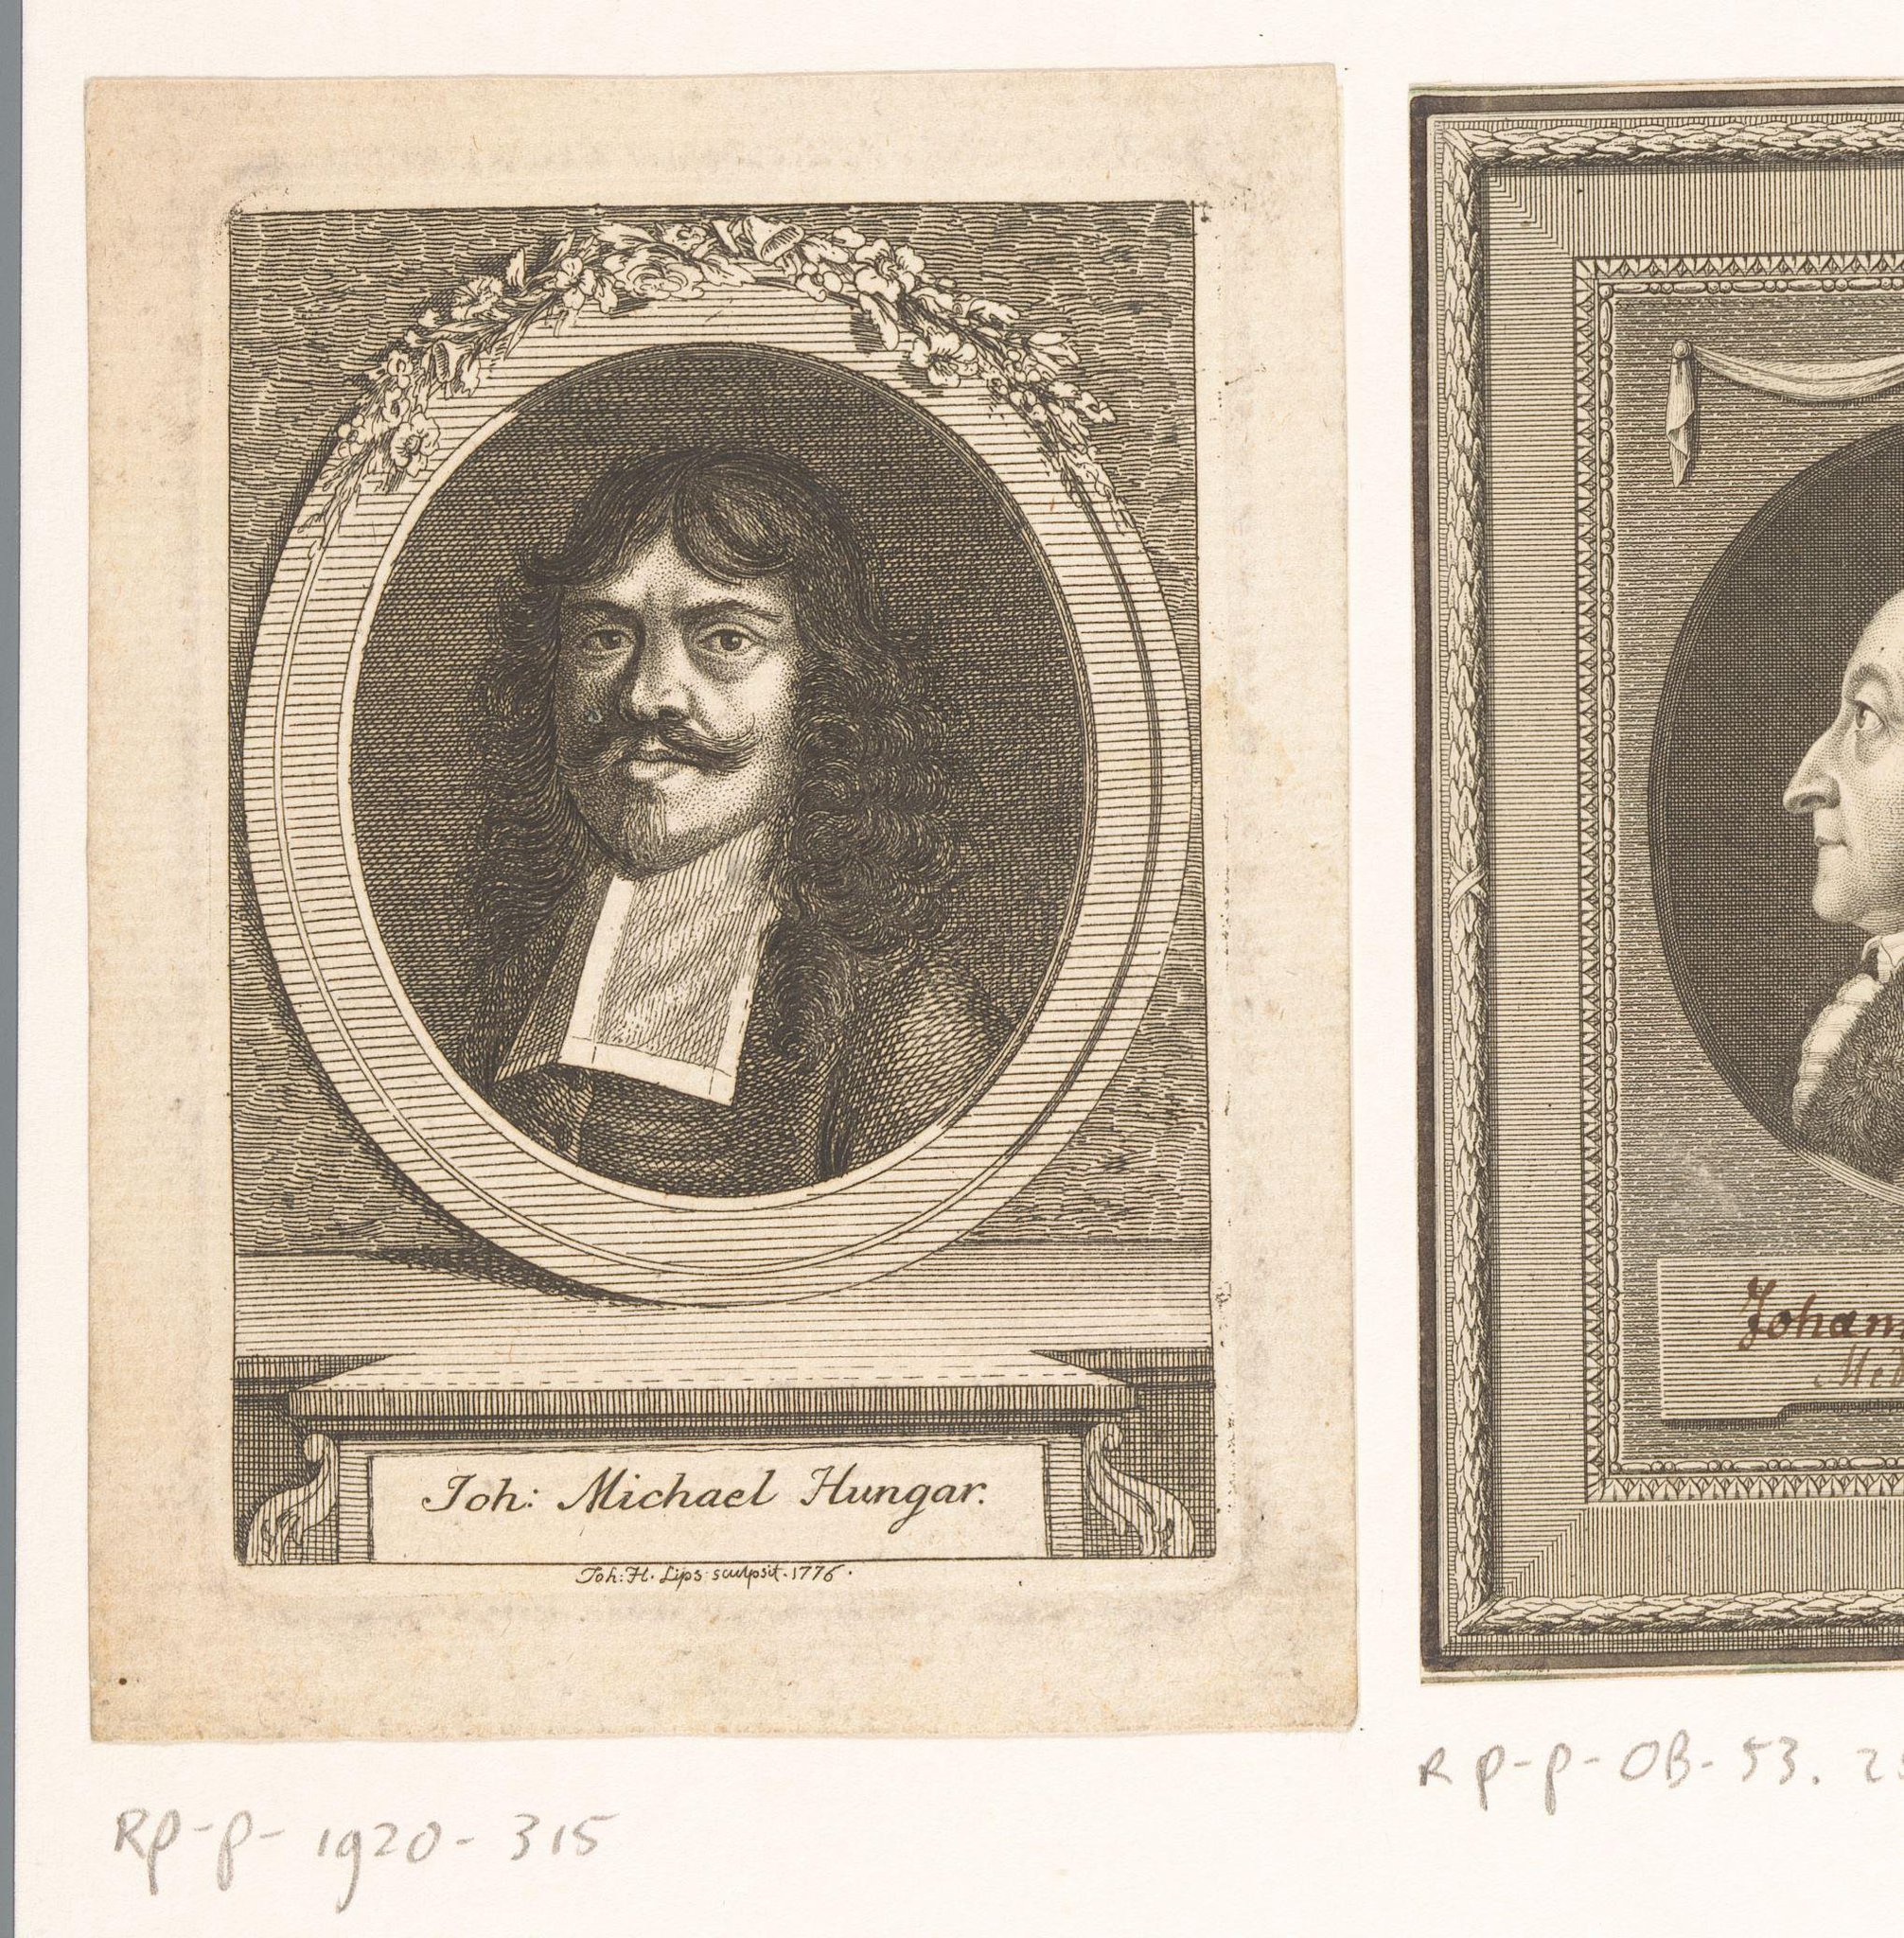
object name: print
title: Portret van Johann Michael Hungar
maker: johann heinrich lips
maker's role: draughtsman, painter, print maker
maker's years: 1758-1817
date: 1776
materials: paper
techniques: etching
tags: print maker, artist, historical persons, portrait, self-portrait of artist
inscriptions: collector's mark: Lugt 2228